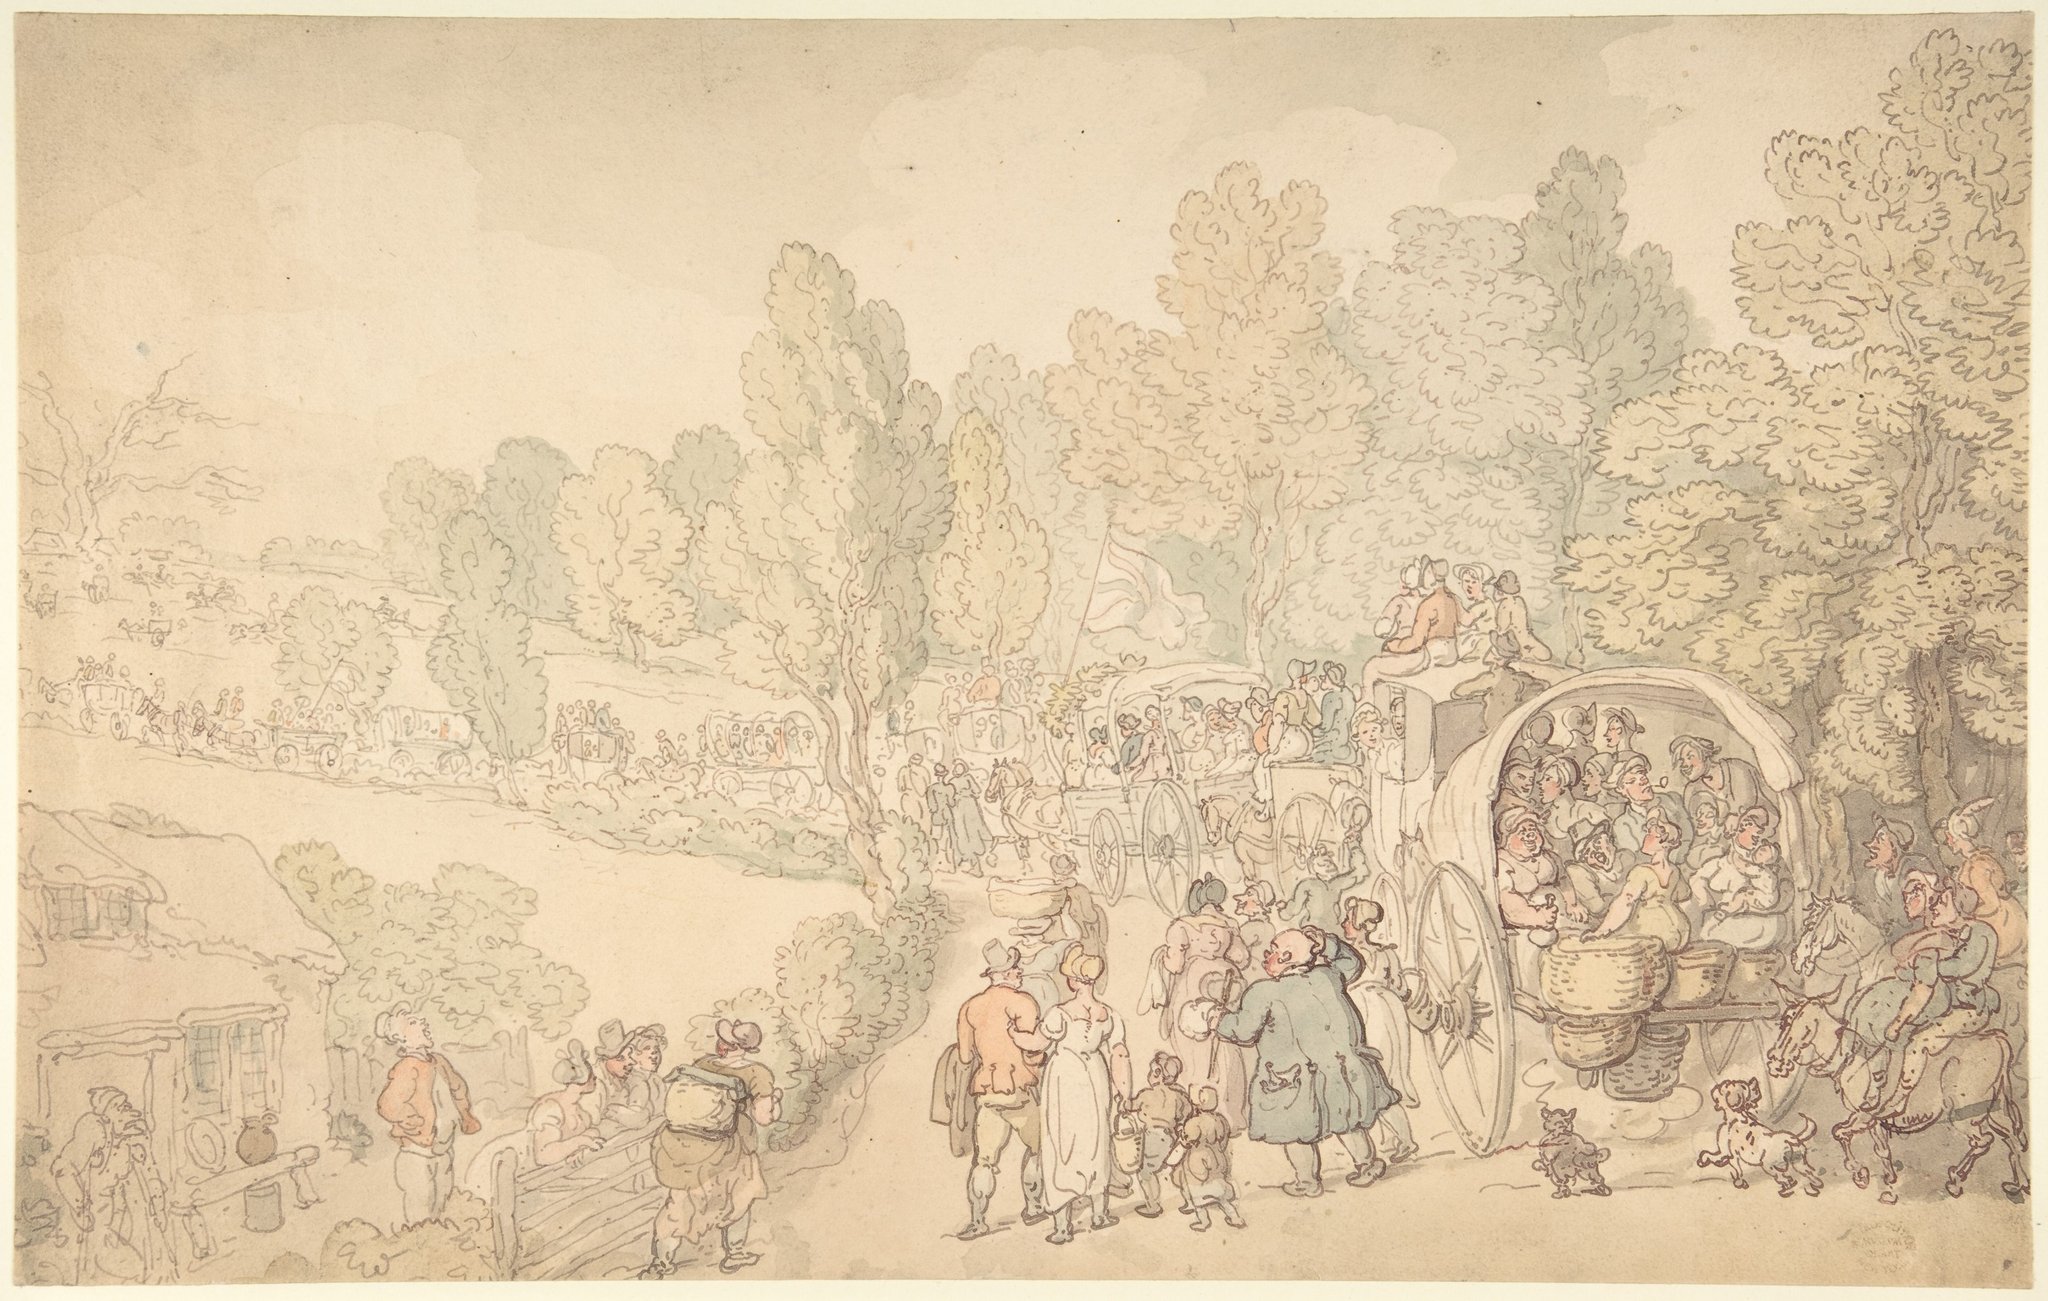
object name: drawing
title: Fairlop Fair, Essex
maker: thomas rowlandson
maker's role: artist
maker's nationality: british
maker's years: 1757-1827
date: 1816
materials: ink, watercolor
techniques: pen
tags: human figures,roads,trees,carriages